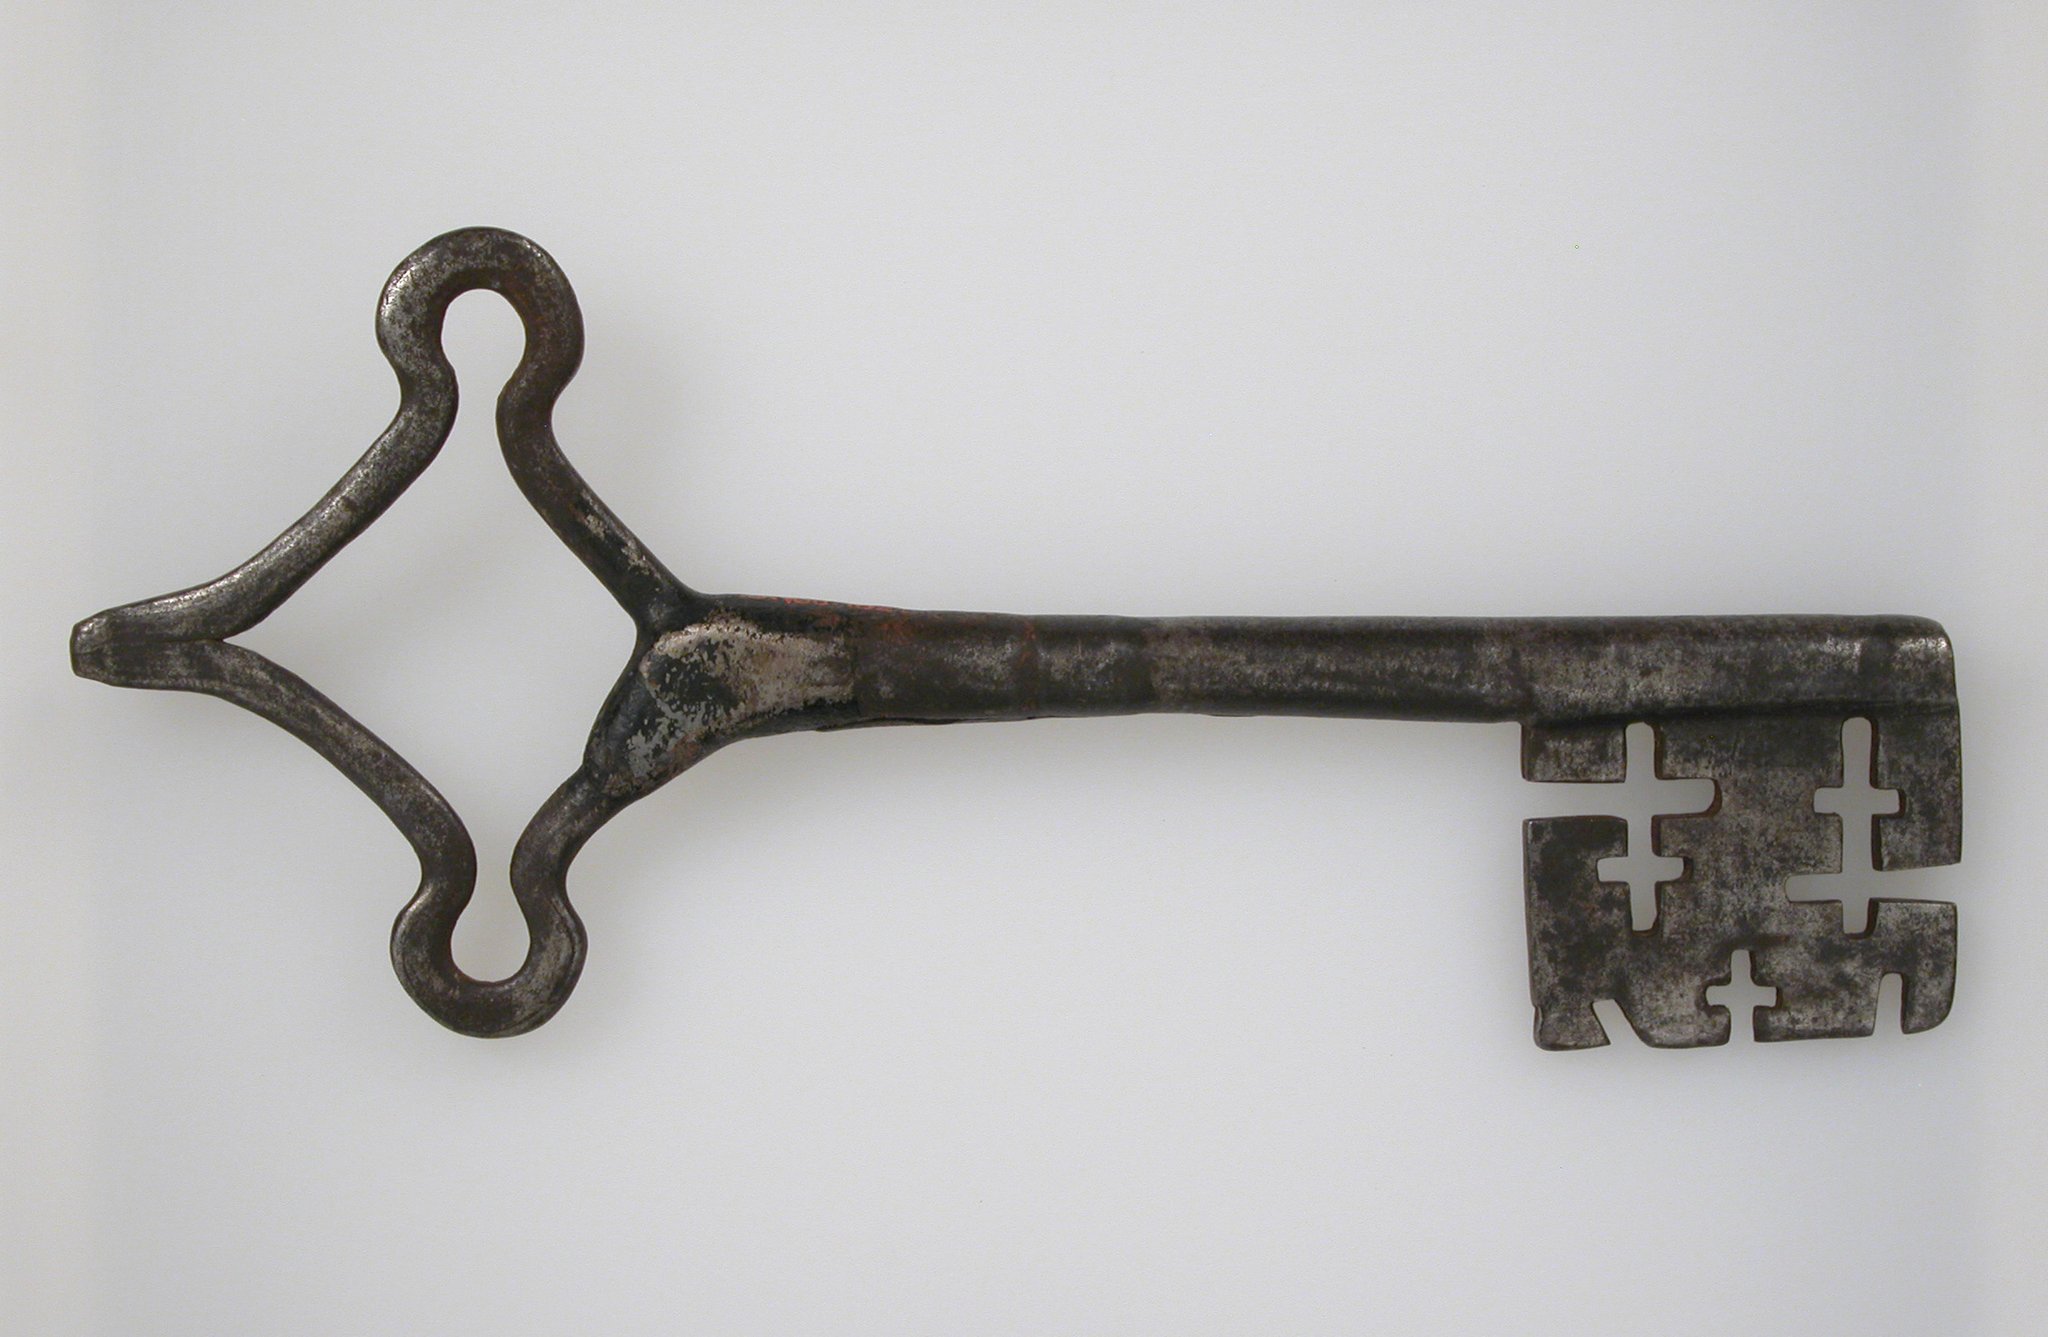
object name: key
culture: german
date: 1301-1400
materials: iron